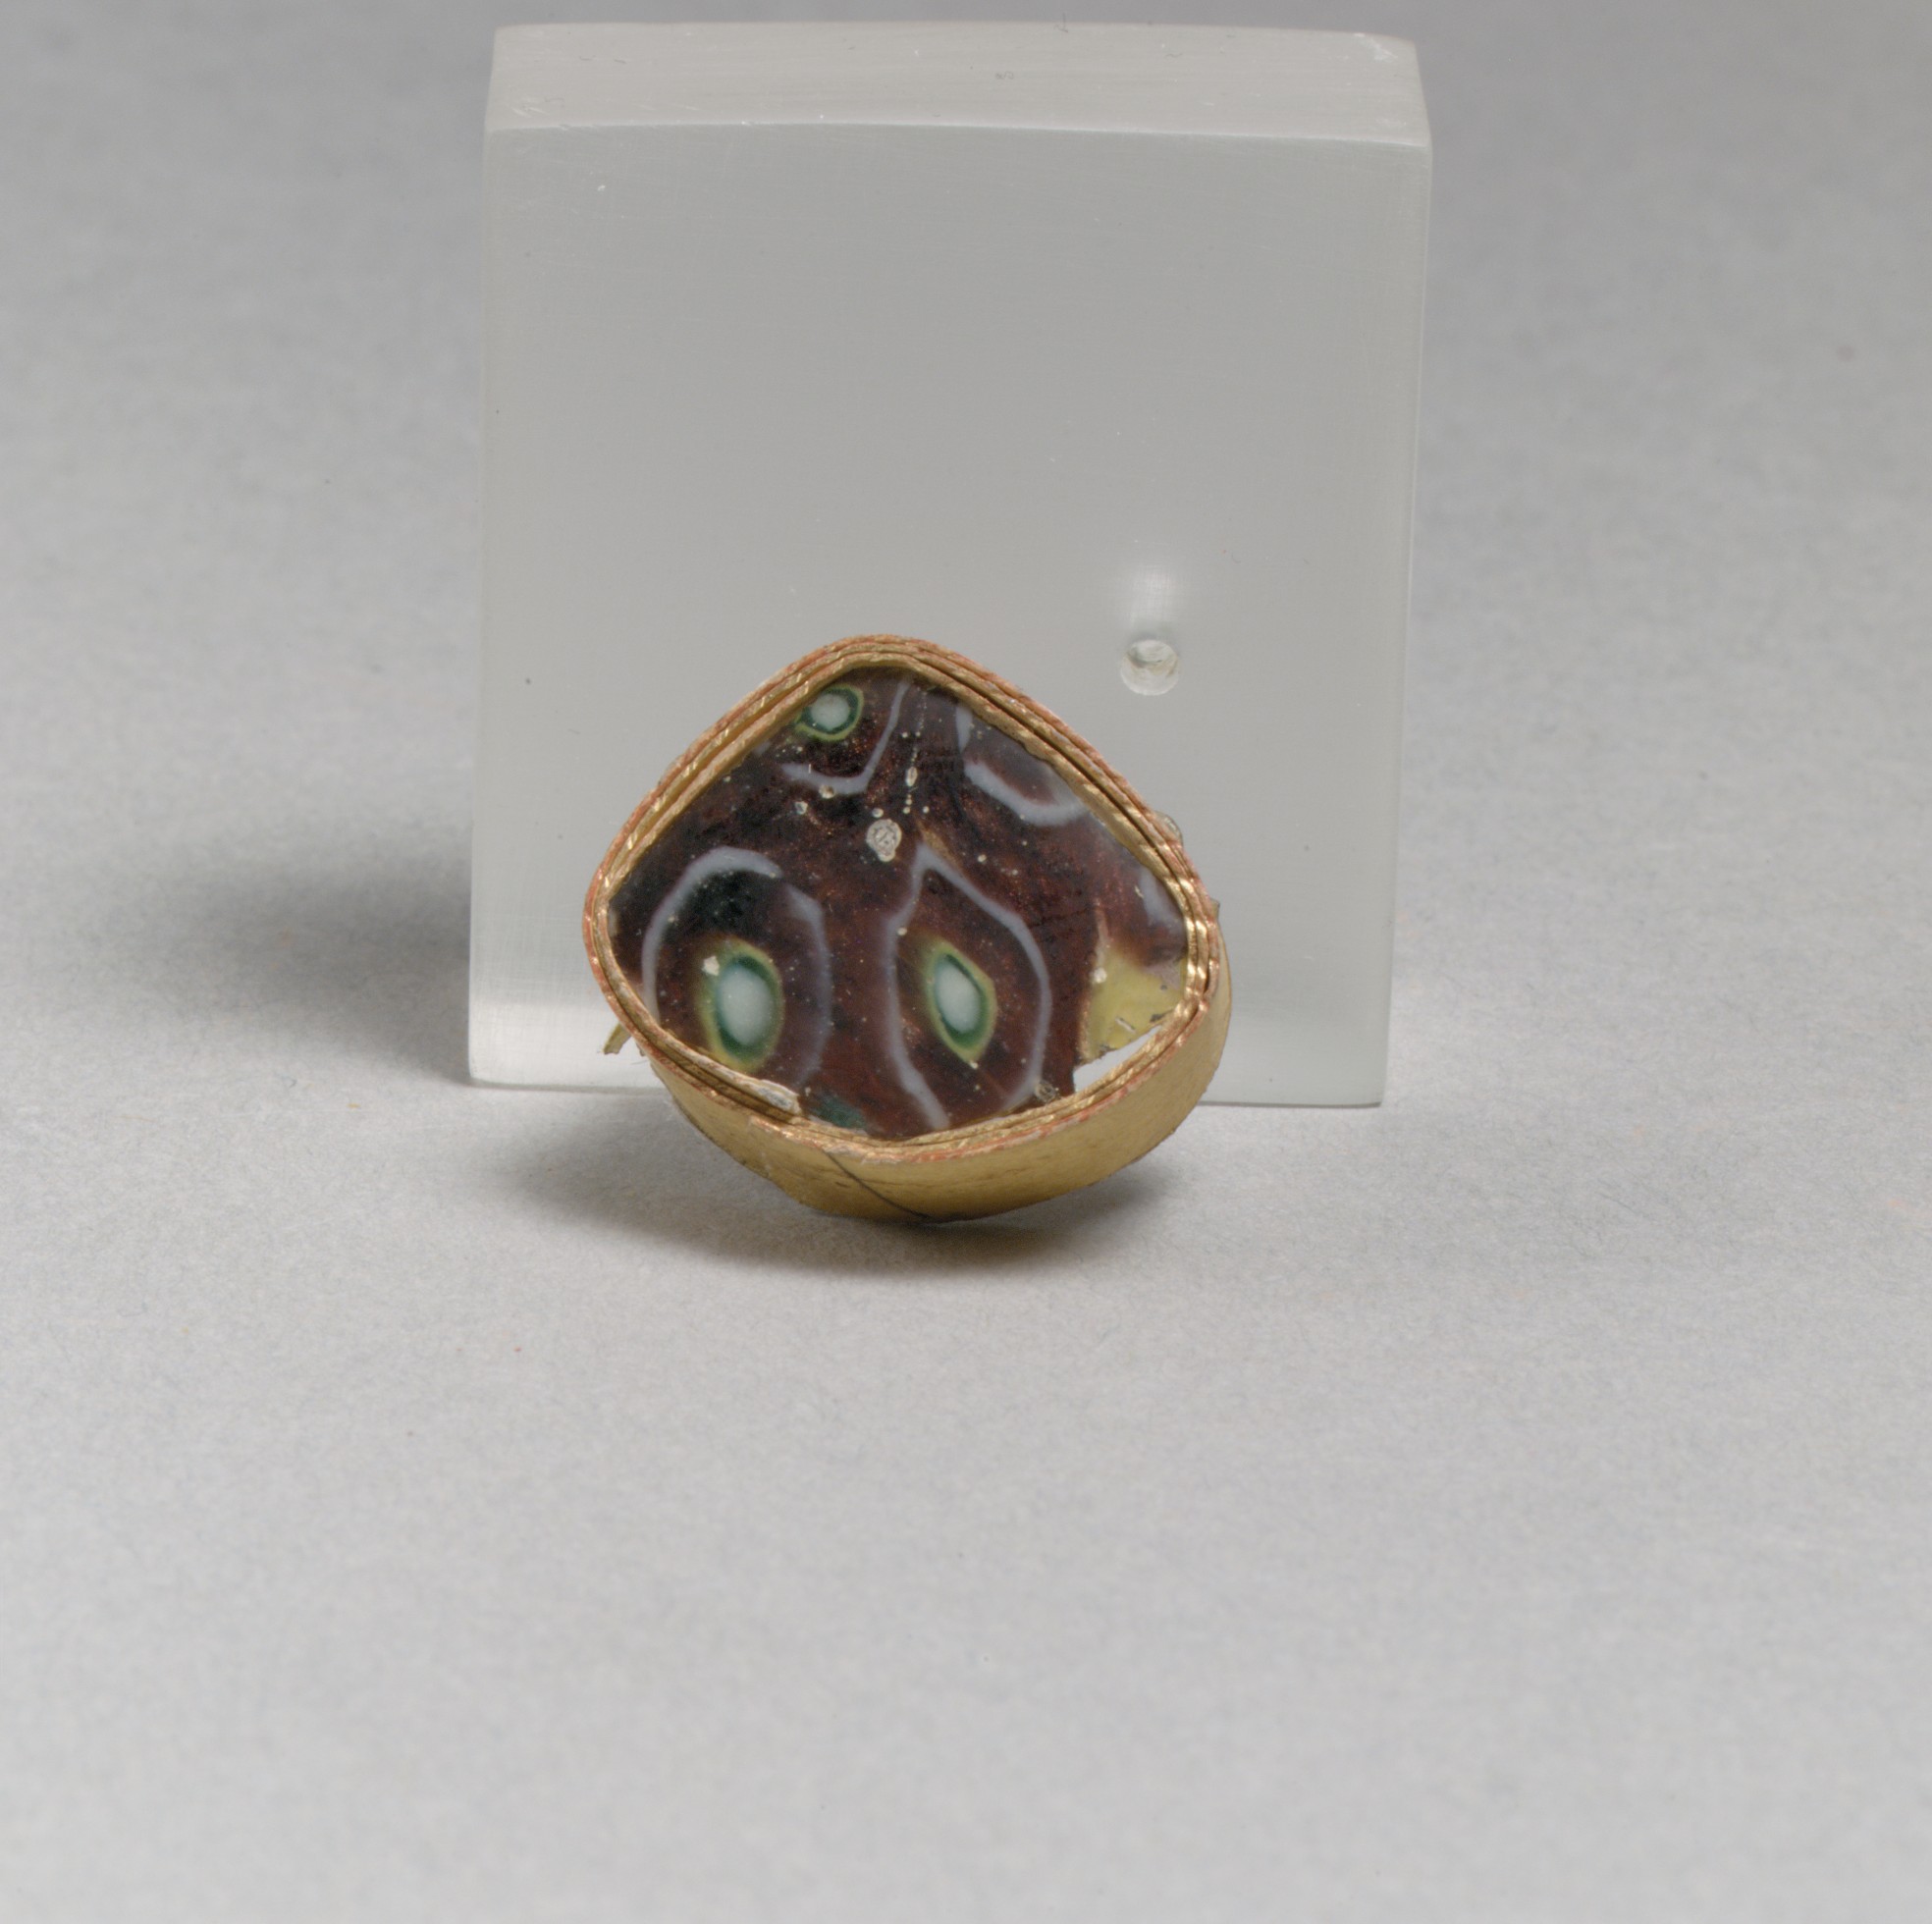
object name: fragment, mosaic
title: Glass mosaic fragment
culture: roman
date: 34 BCE-33 CE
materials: glass